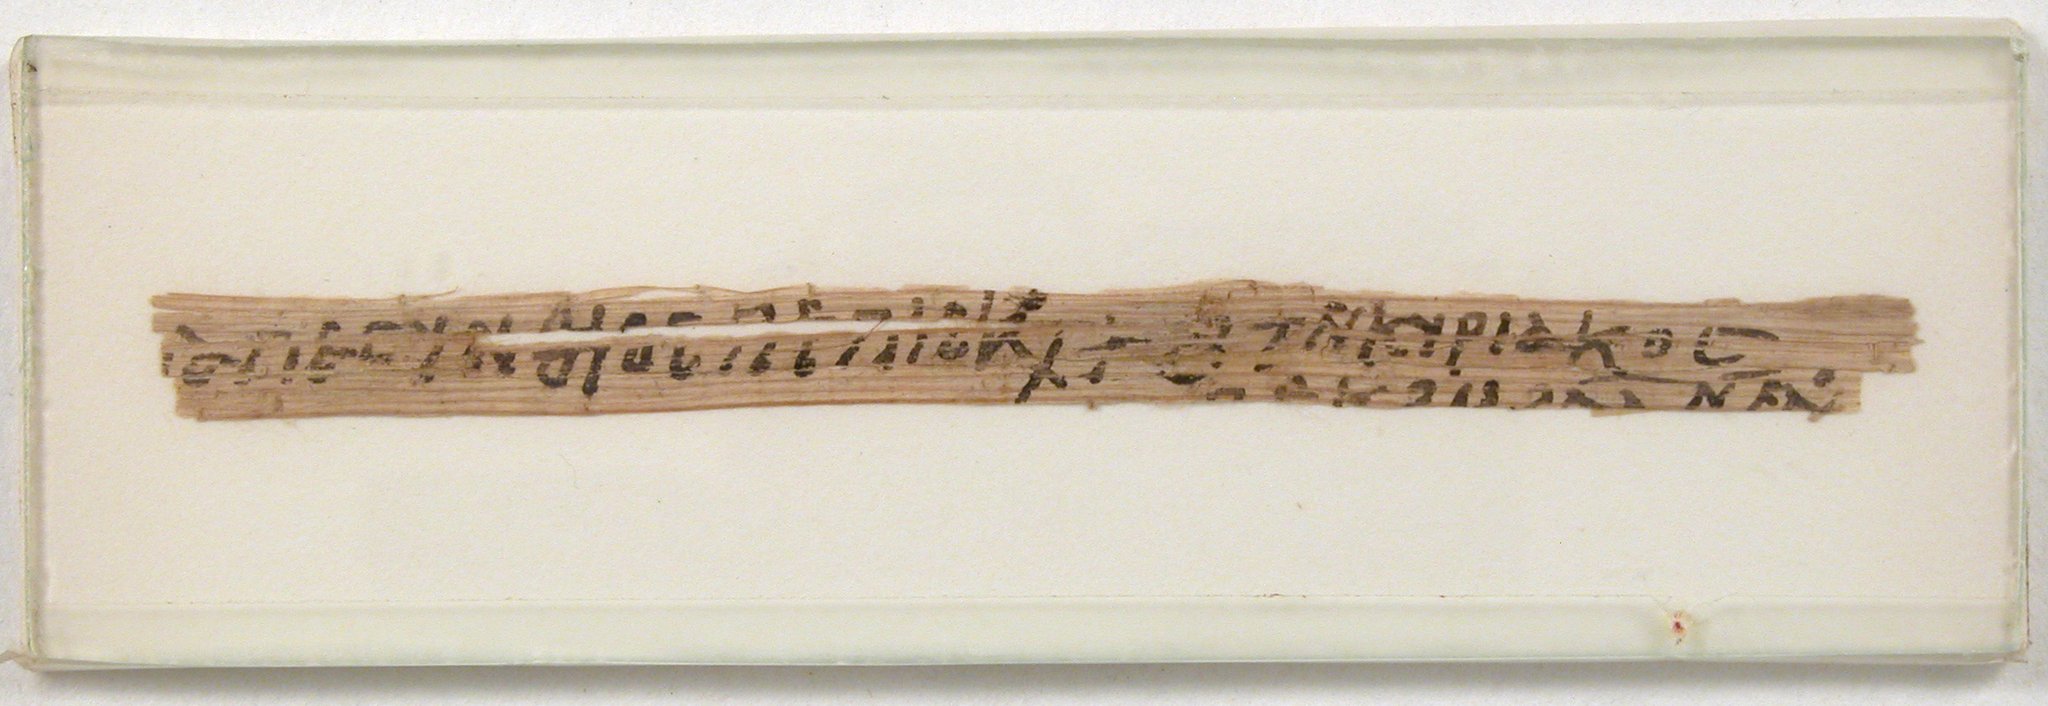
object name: fragment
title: Papyrus Fragment from Cyriacus to Bishop Pesynthius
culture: coptic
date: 580-640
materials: ink, papyrus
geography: egypt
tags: coptic